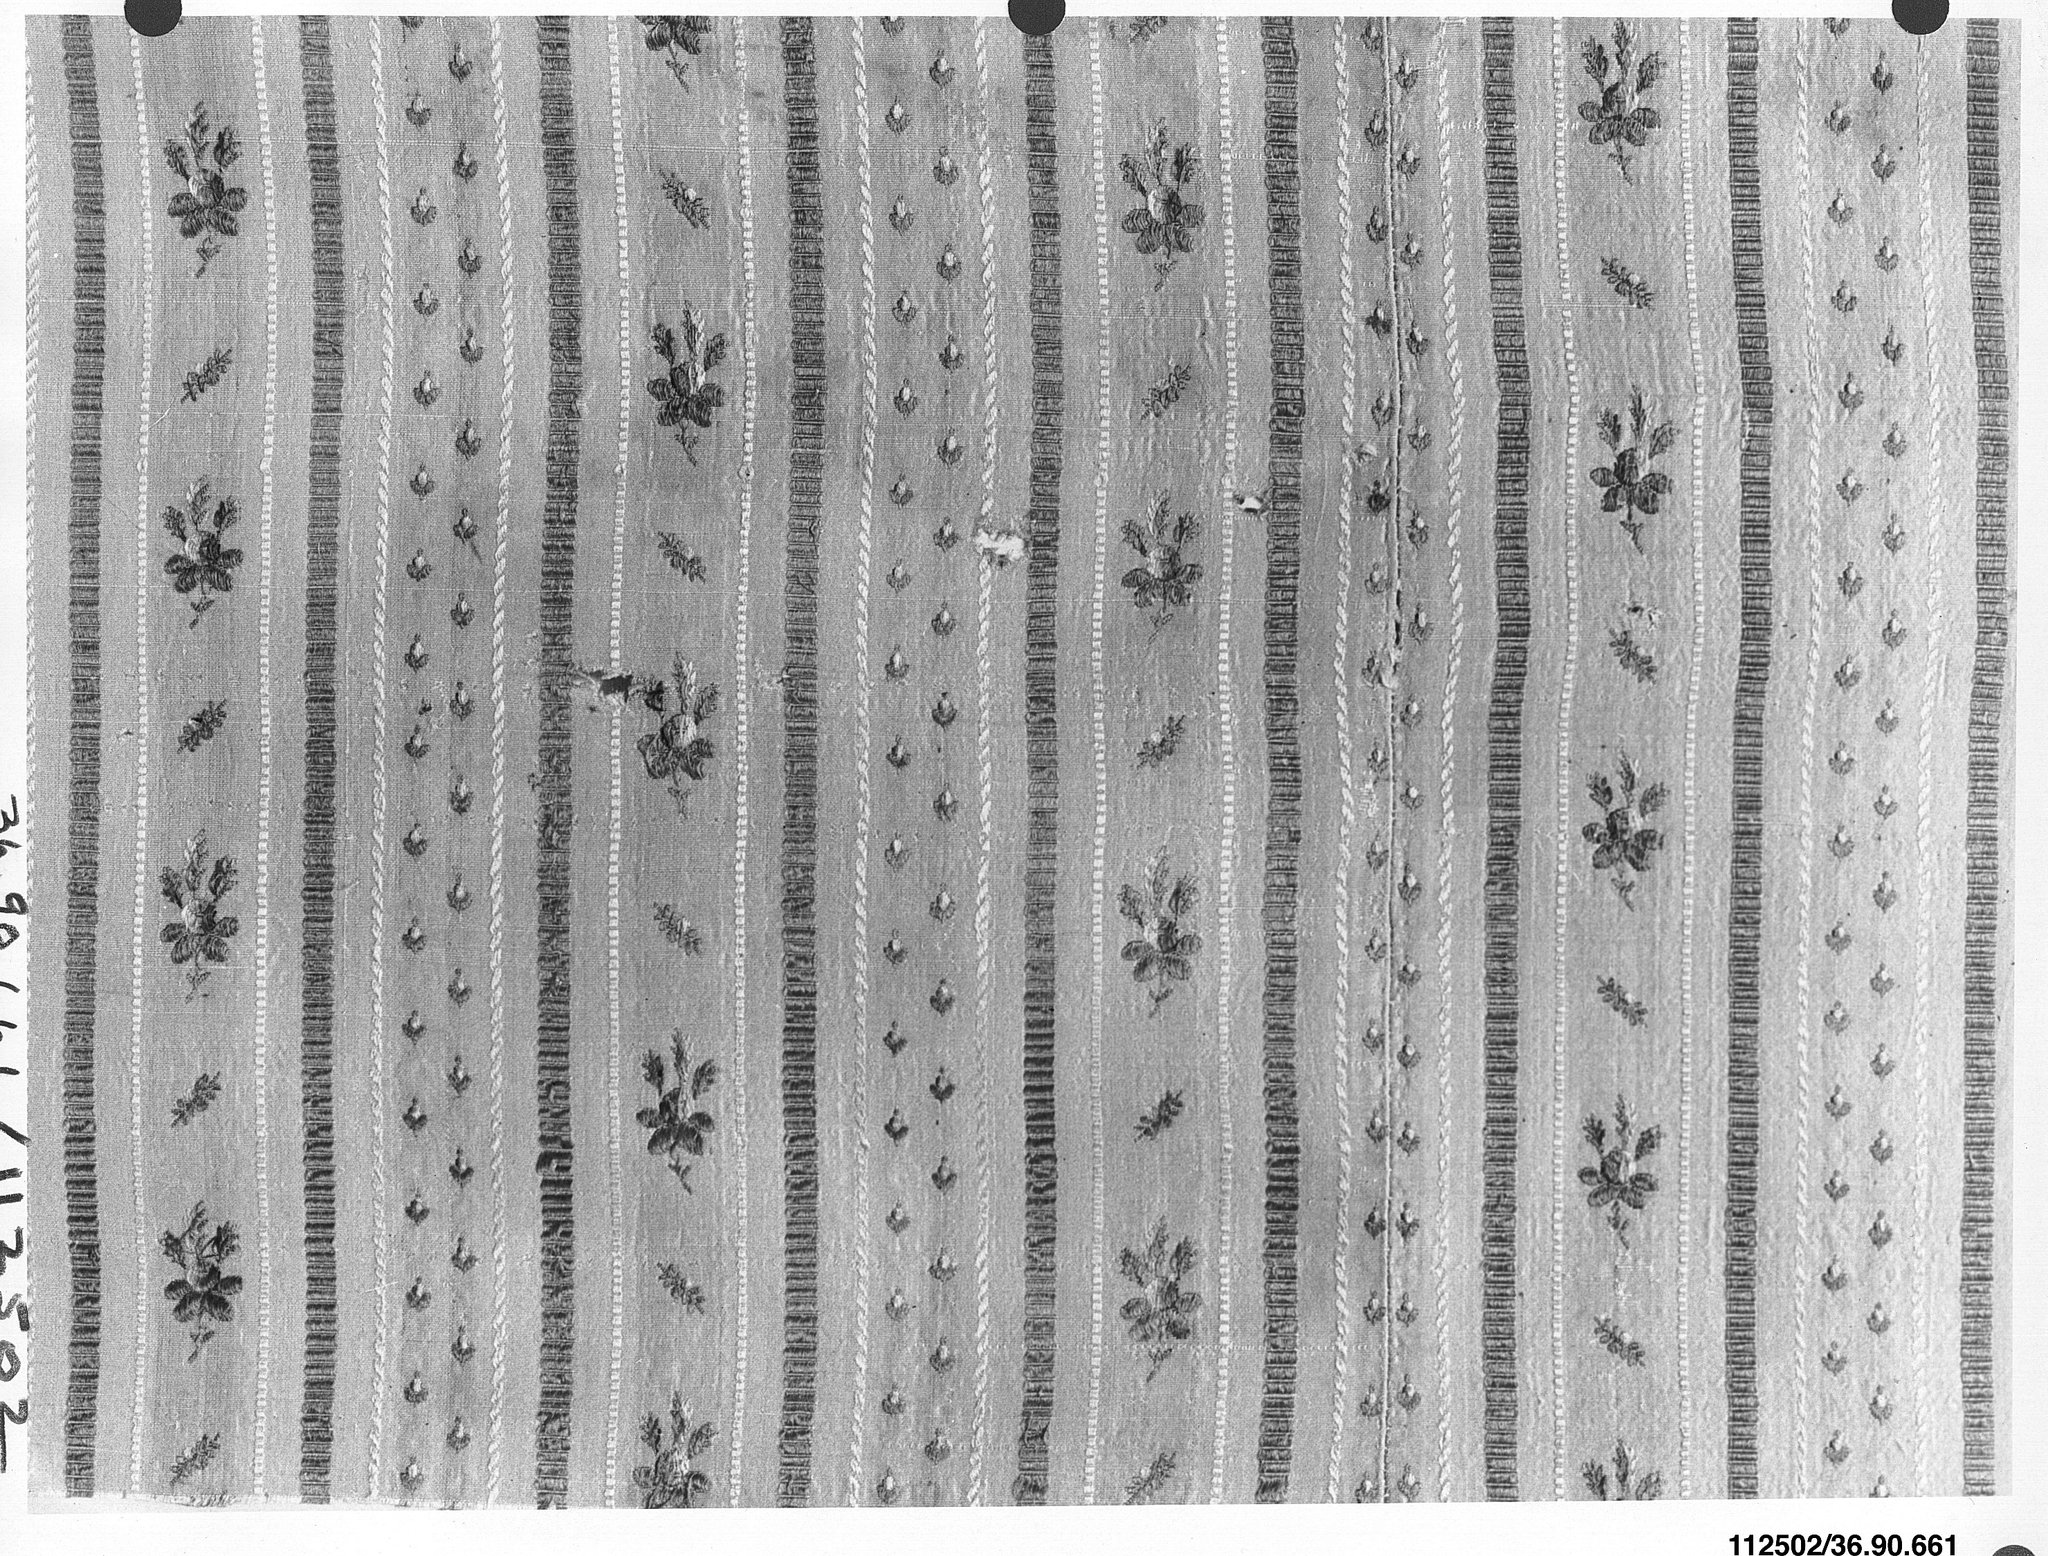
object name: piece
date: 1701-1800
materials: silk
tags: flowers